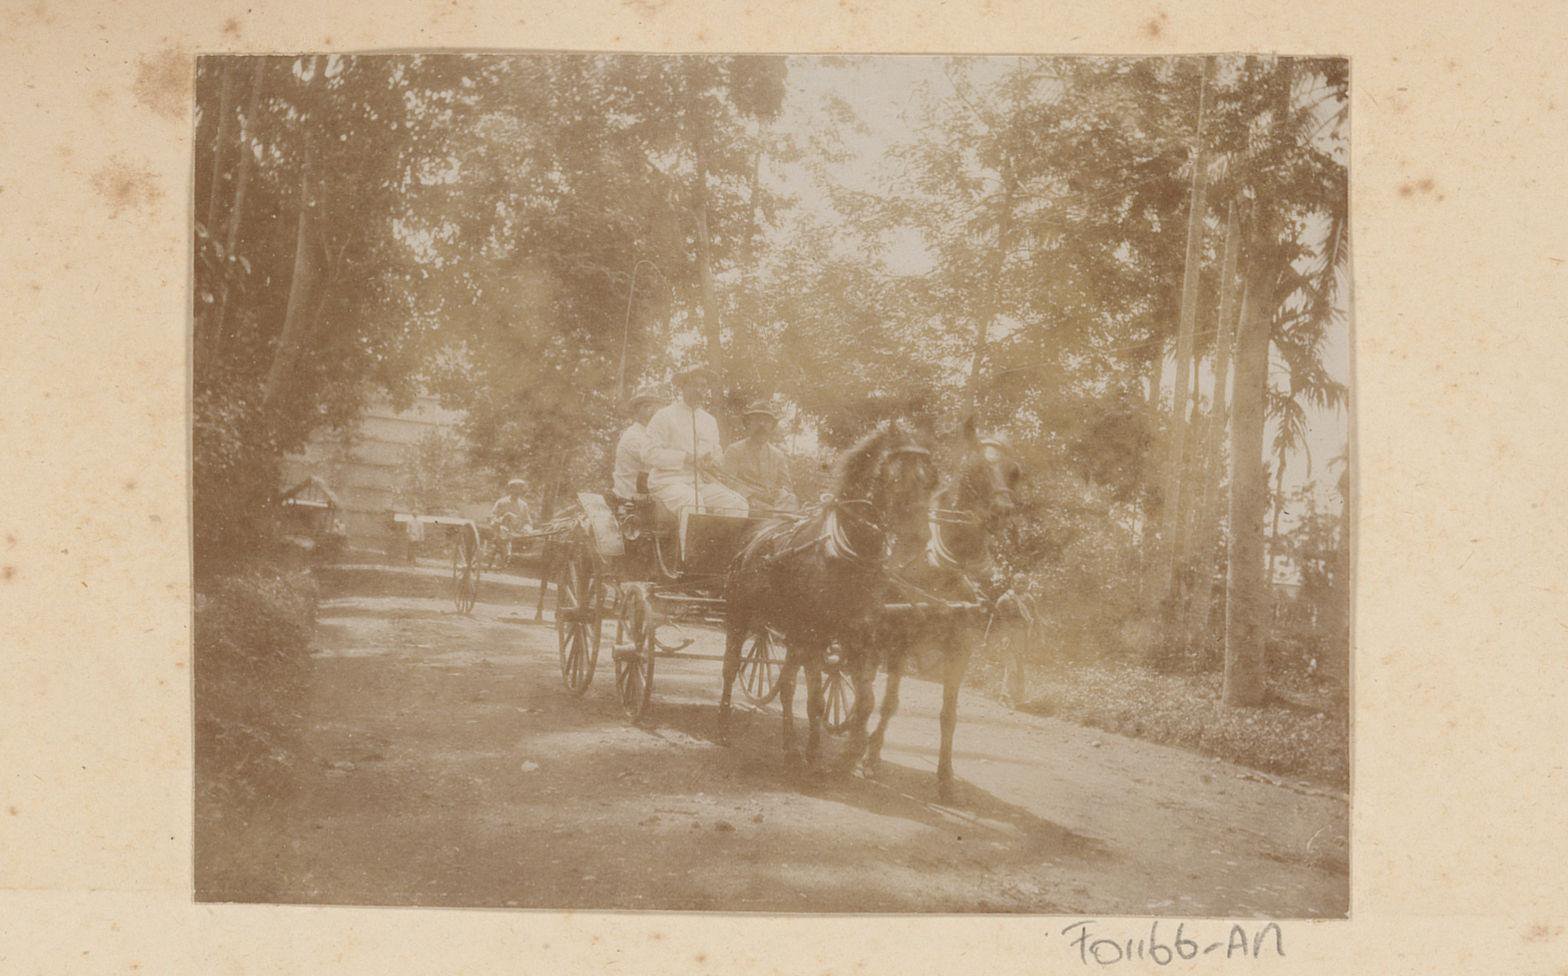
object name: album leaf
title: Nederlanders in een door paarden getrokken kar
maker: Anonymous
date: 1890-1910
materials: photographic support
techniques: collodion silver print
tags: europeans, four-wheeled, animal-drawn vehicle, e.g.: cab, carriage, coach, historical persons, horse, dutch east indies, the